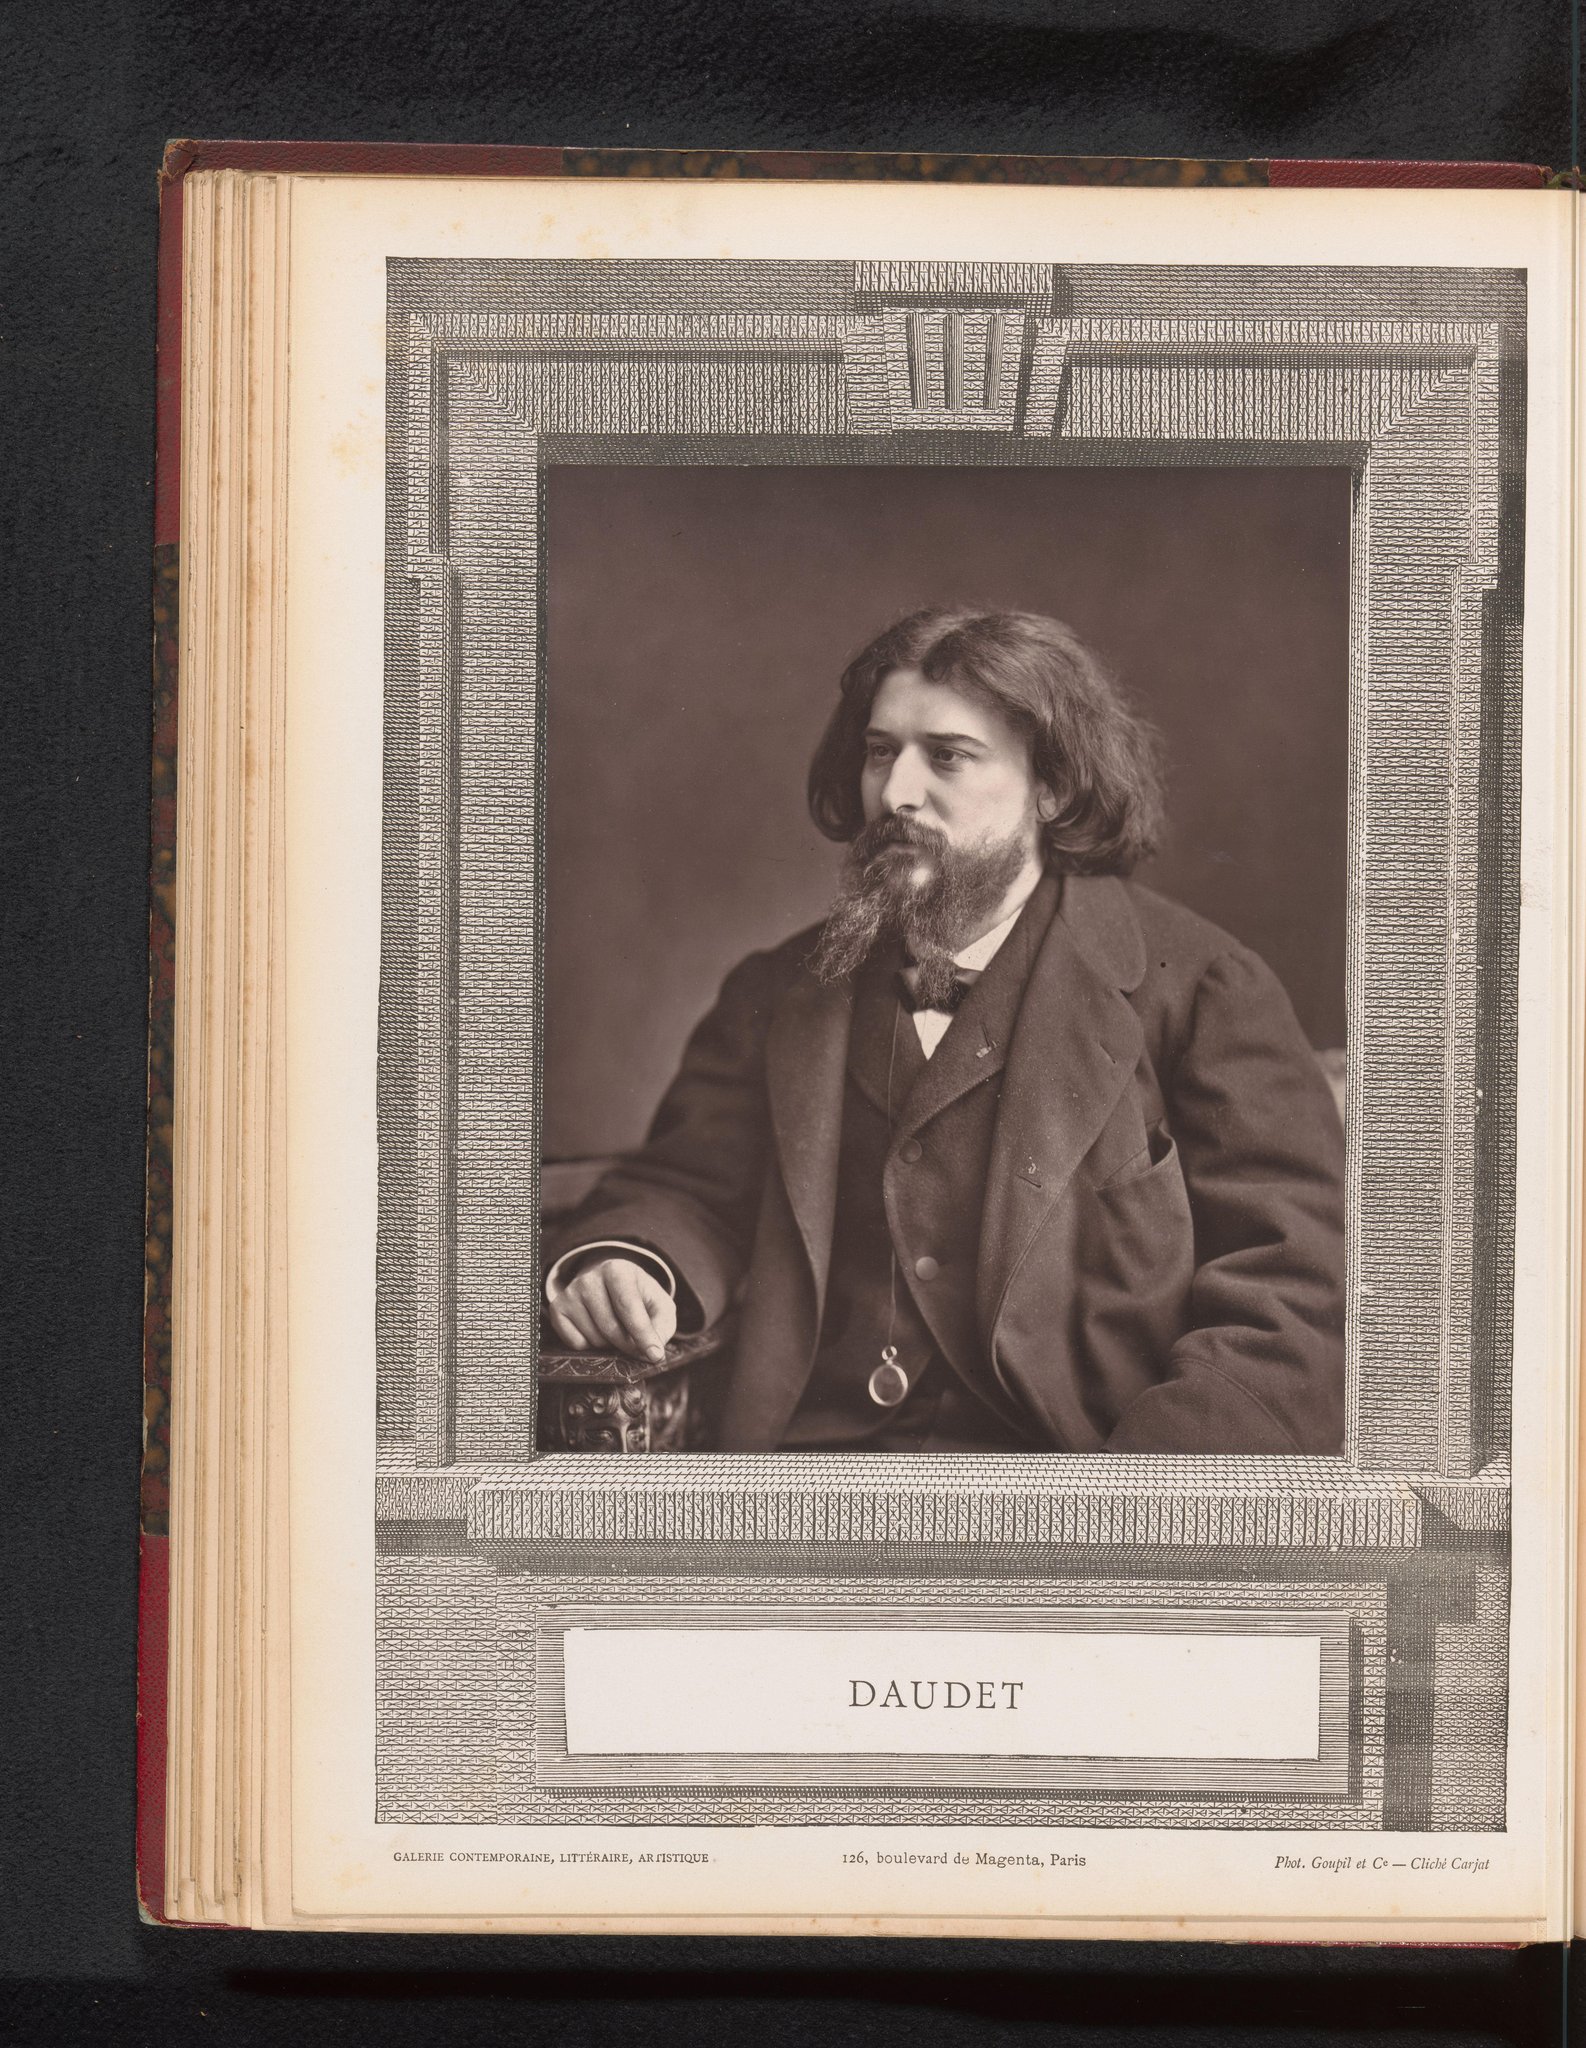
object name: page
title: Portret van Alphonse Daudet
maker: étienne carjat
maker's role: draughtsman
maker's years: 1828-1906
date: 1871-1876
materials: paper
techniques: woodburytype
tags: alphonse daudet, adult man, historical persons